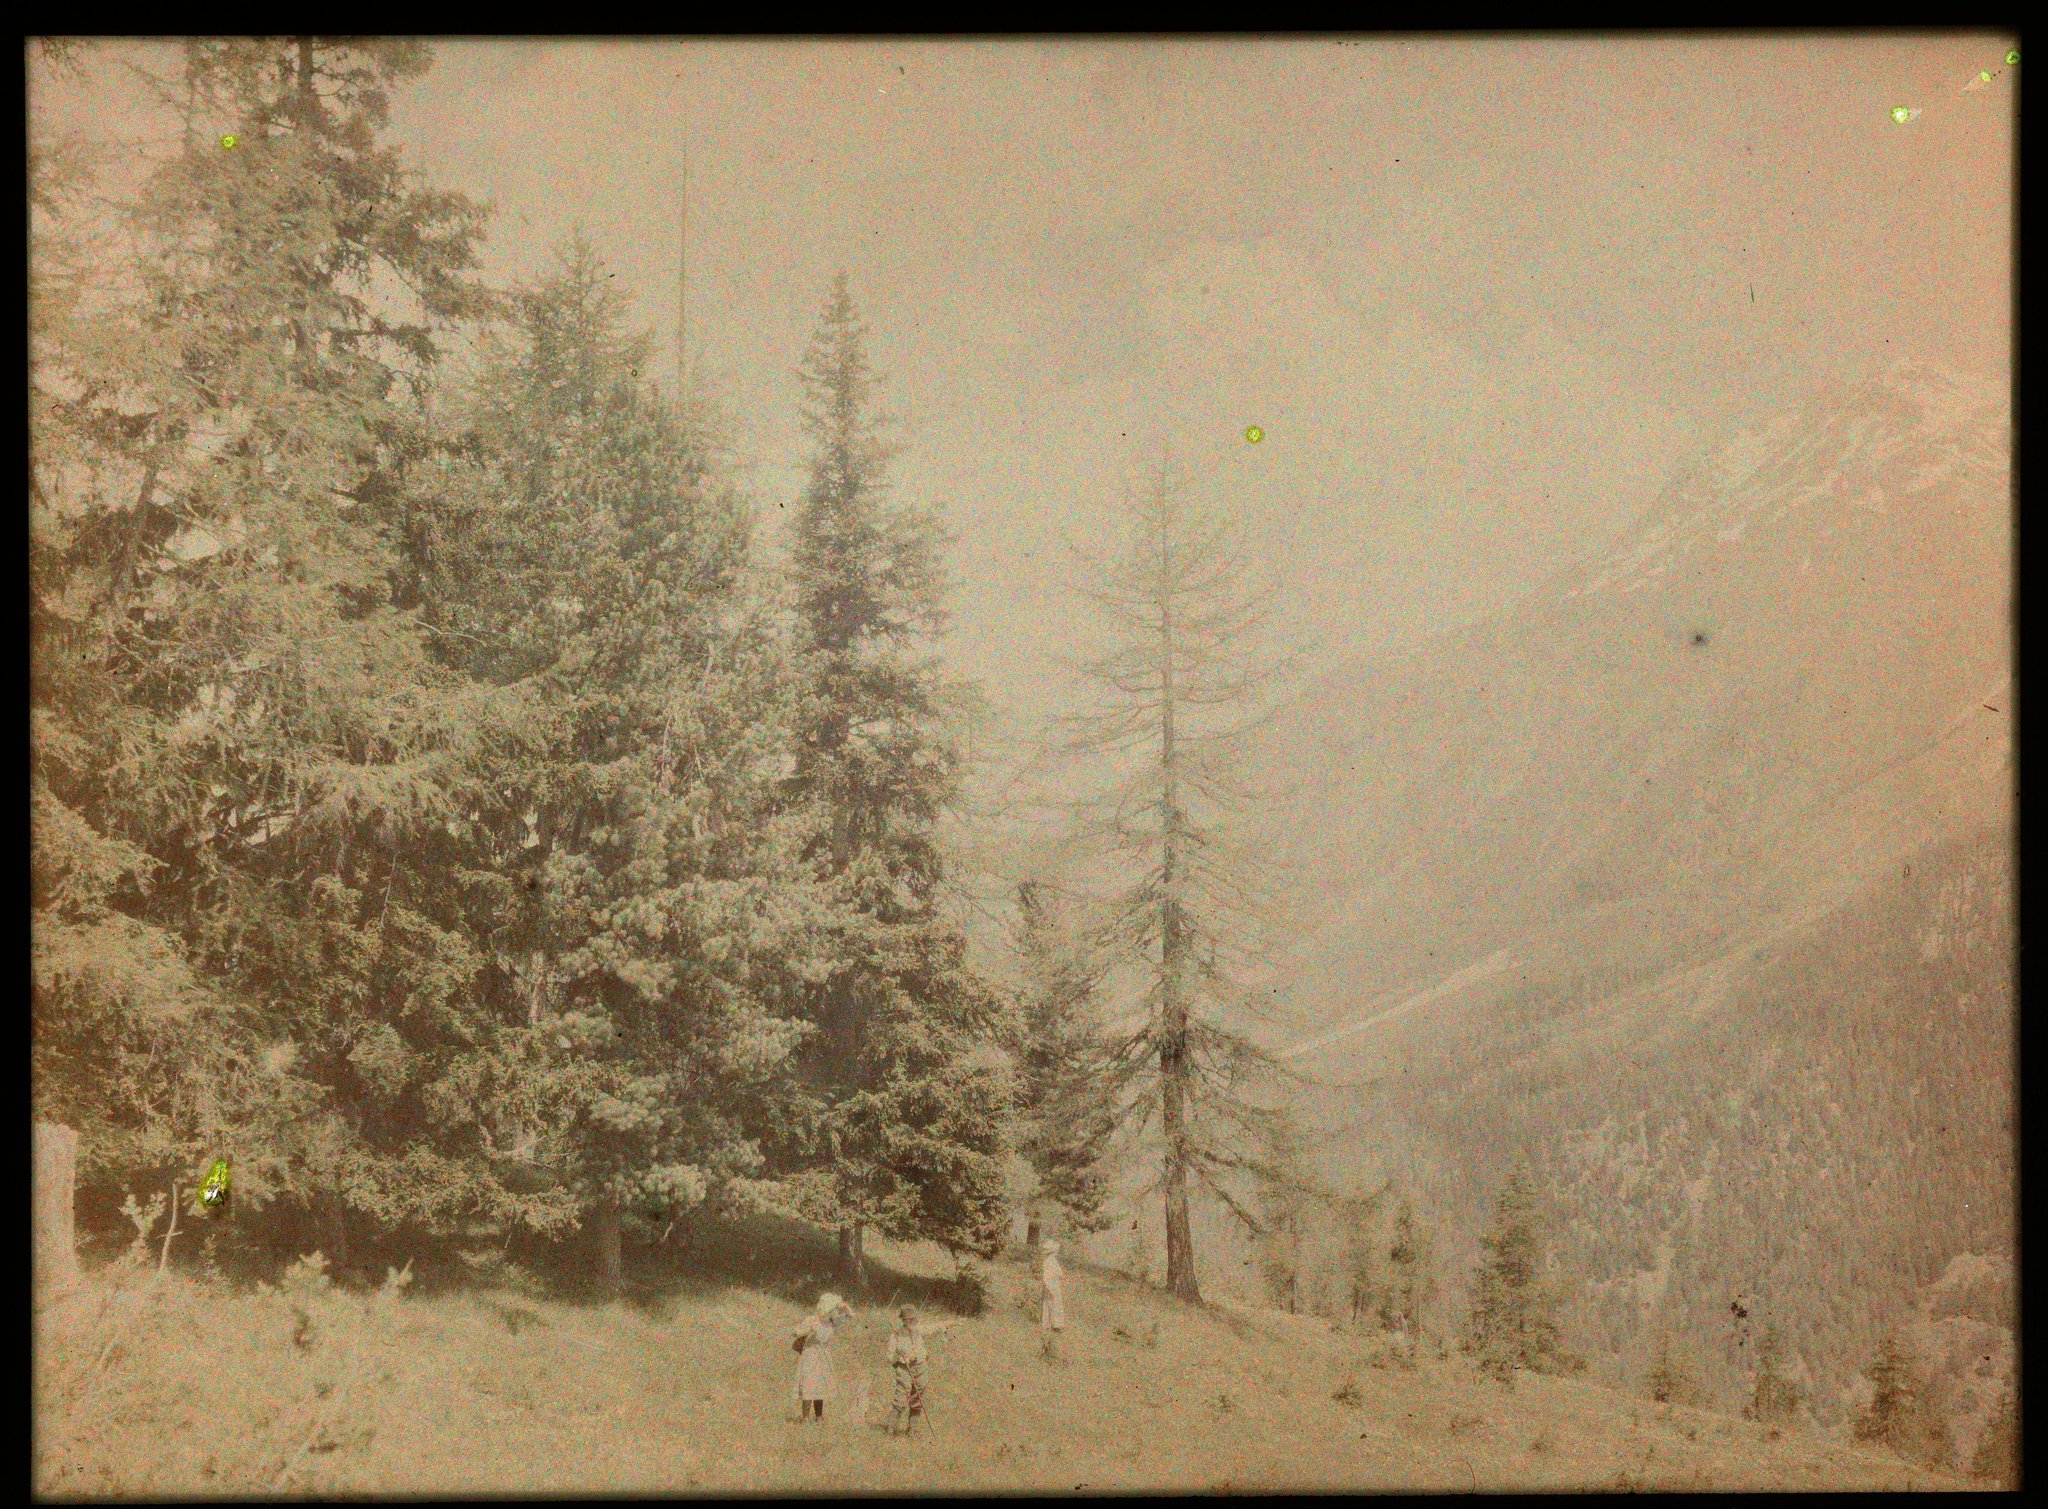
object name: photograph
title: Berglandschap met drie figuren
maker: adolphe burdet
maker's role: fotograaf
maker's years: 1860-1940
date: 1907-1930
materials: glass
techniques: autochrome process, slide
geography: netherlands